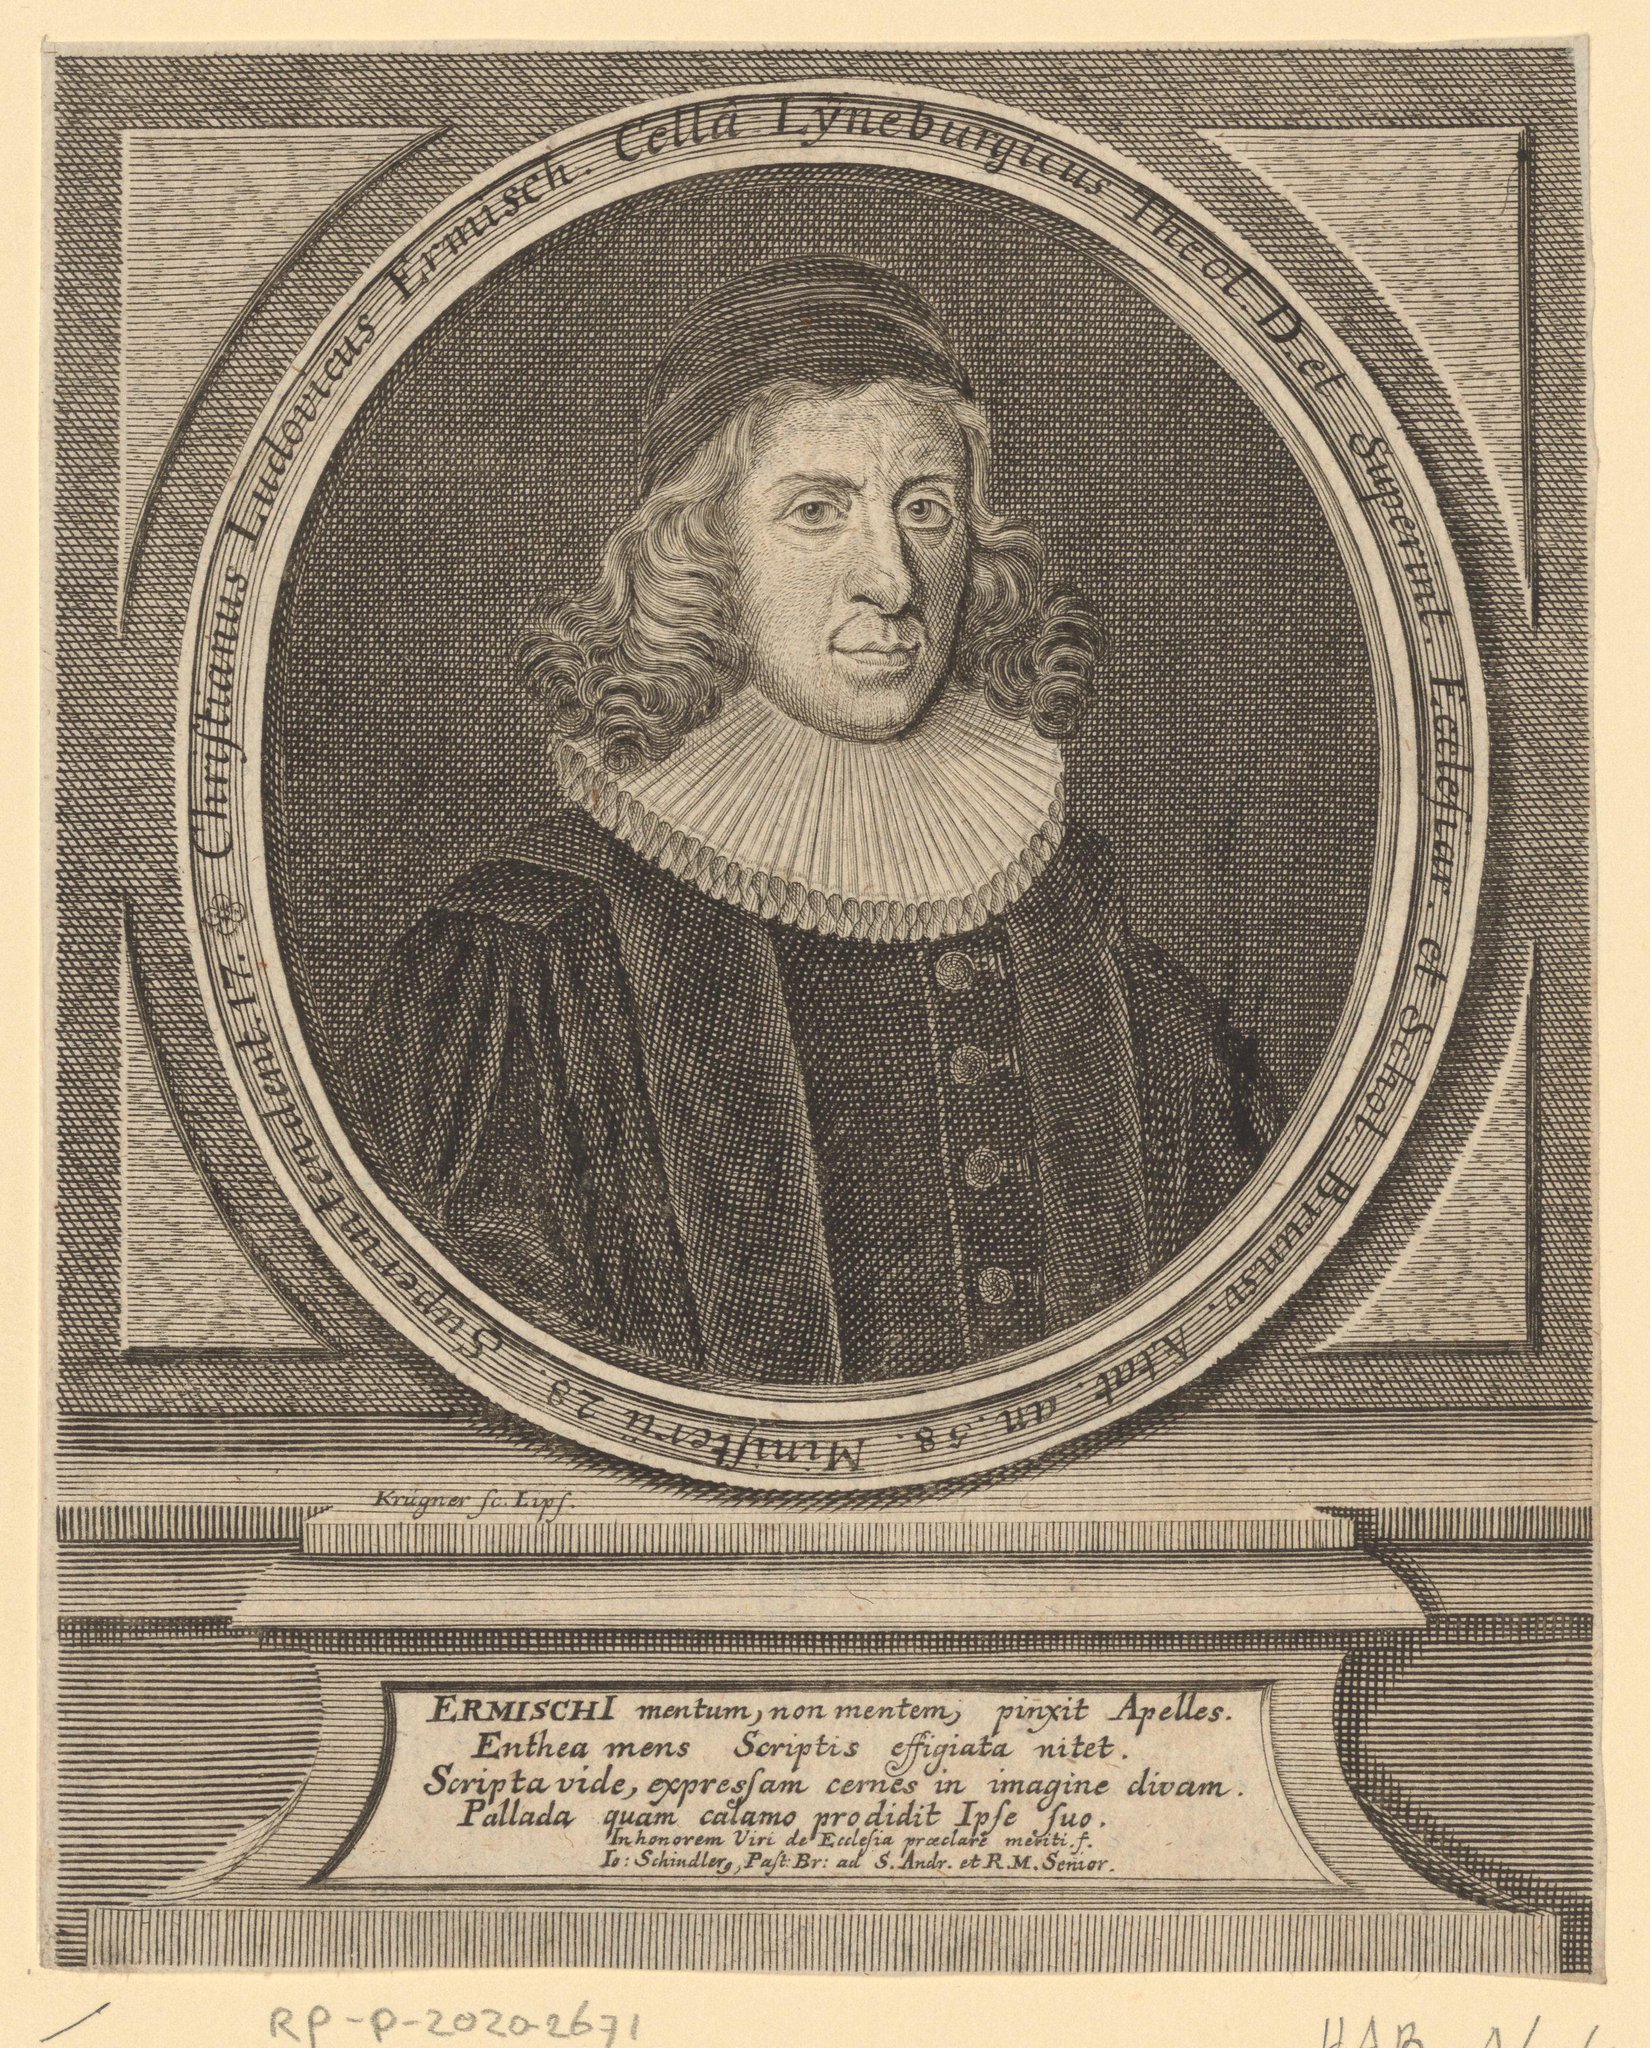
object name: book illustration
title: Portret van Christian Ludwig Ermisch op 58-jarige leeftijd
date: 1710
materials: paper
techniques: engraving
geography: leipzig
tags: theologian, historical persons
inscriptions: collector's mark: Lugt 240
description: Prent waarschijnlijk uit: Ermisch, Christian Ludwig. Leichen- und Miscellan-Predigten (...). Leipzig: Johann Ludwig Gleditsch, 1710.